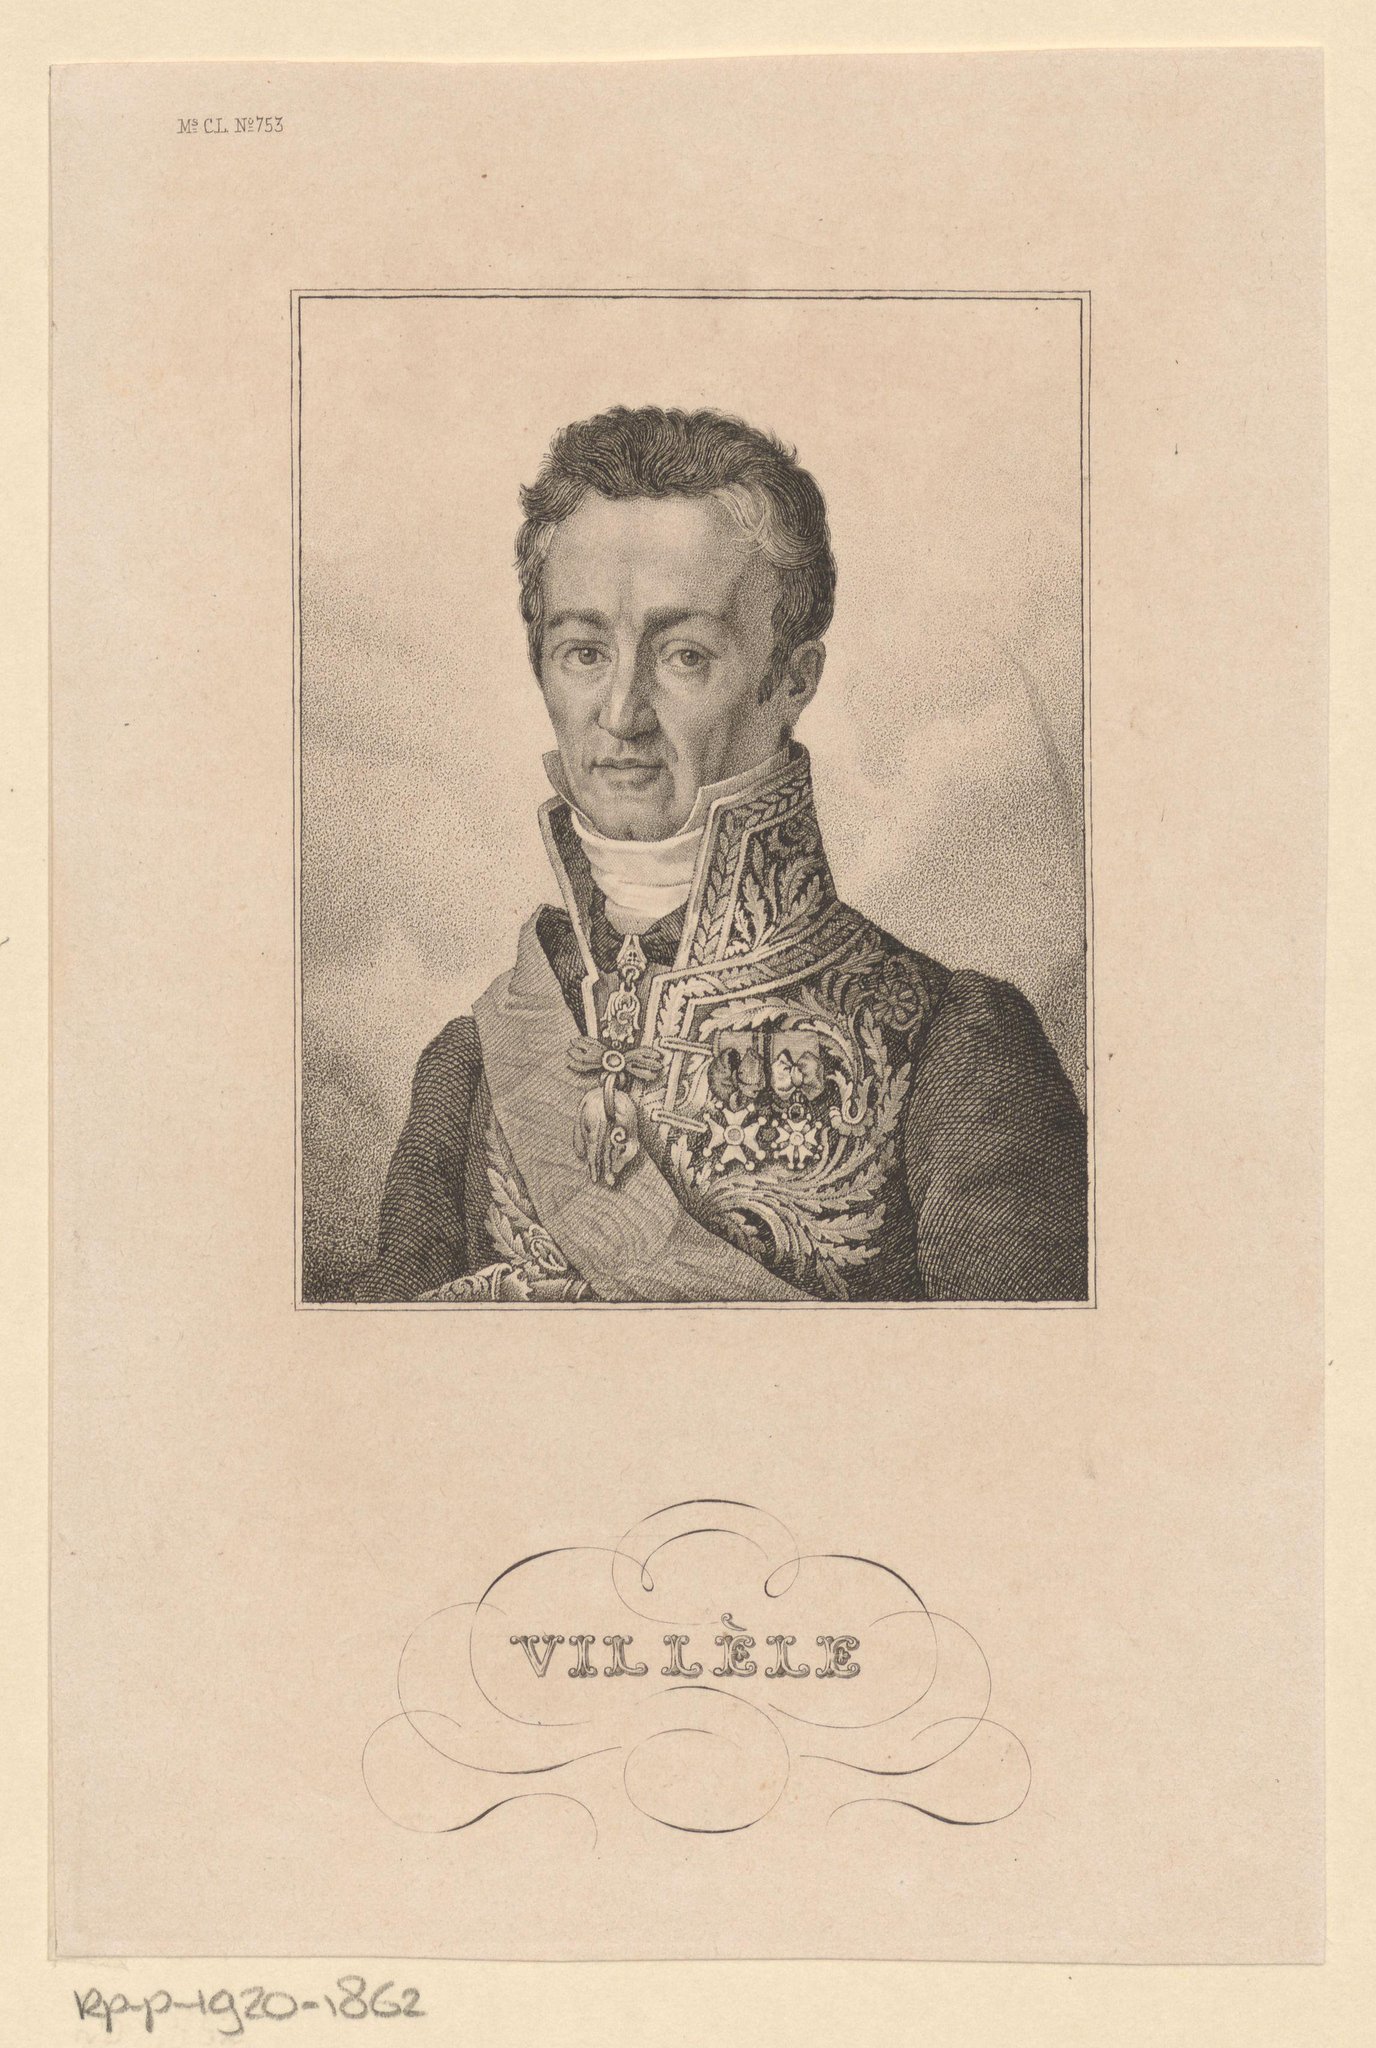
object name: print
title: Portret van Joseph de Villèle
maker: Anonymous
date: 1840-1855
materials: paper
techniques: etching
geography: germany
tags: historical persons, politician, e.g. party leader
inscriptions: collector's mark: Lugt 2228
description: Prent waarschijnlijk uit: Meyer, Joseph. Das große Conversations-Lexikon für die gebildeten Stände. 52 dln. Hildburghausen: Bibliographisches Institut, [1839-1855].